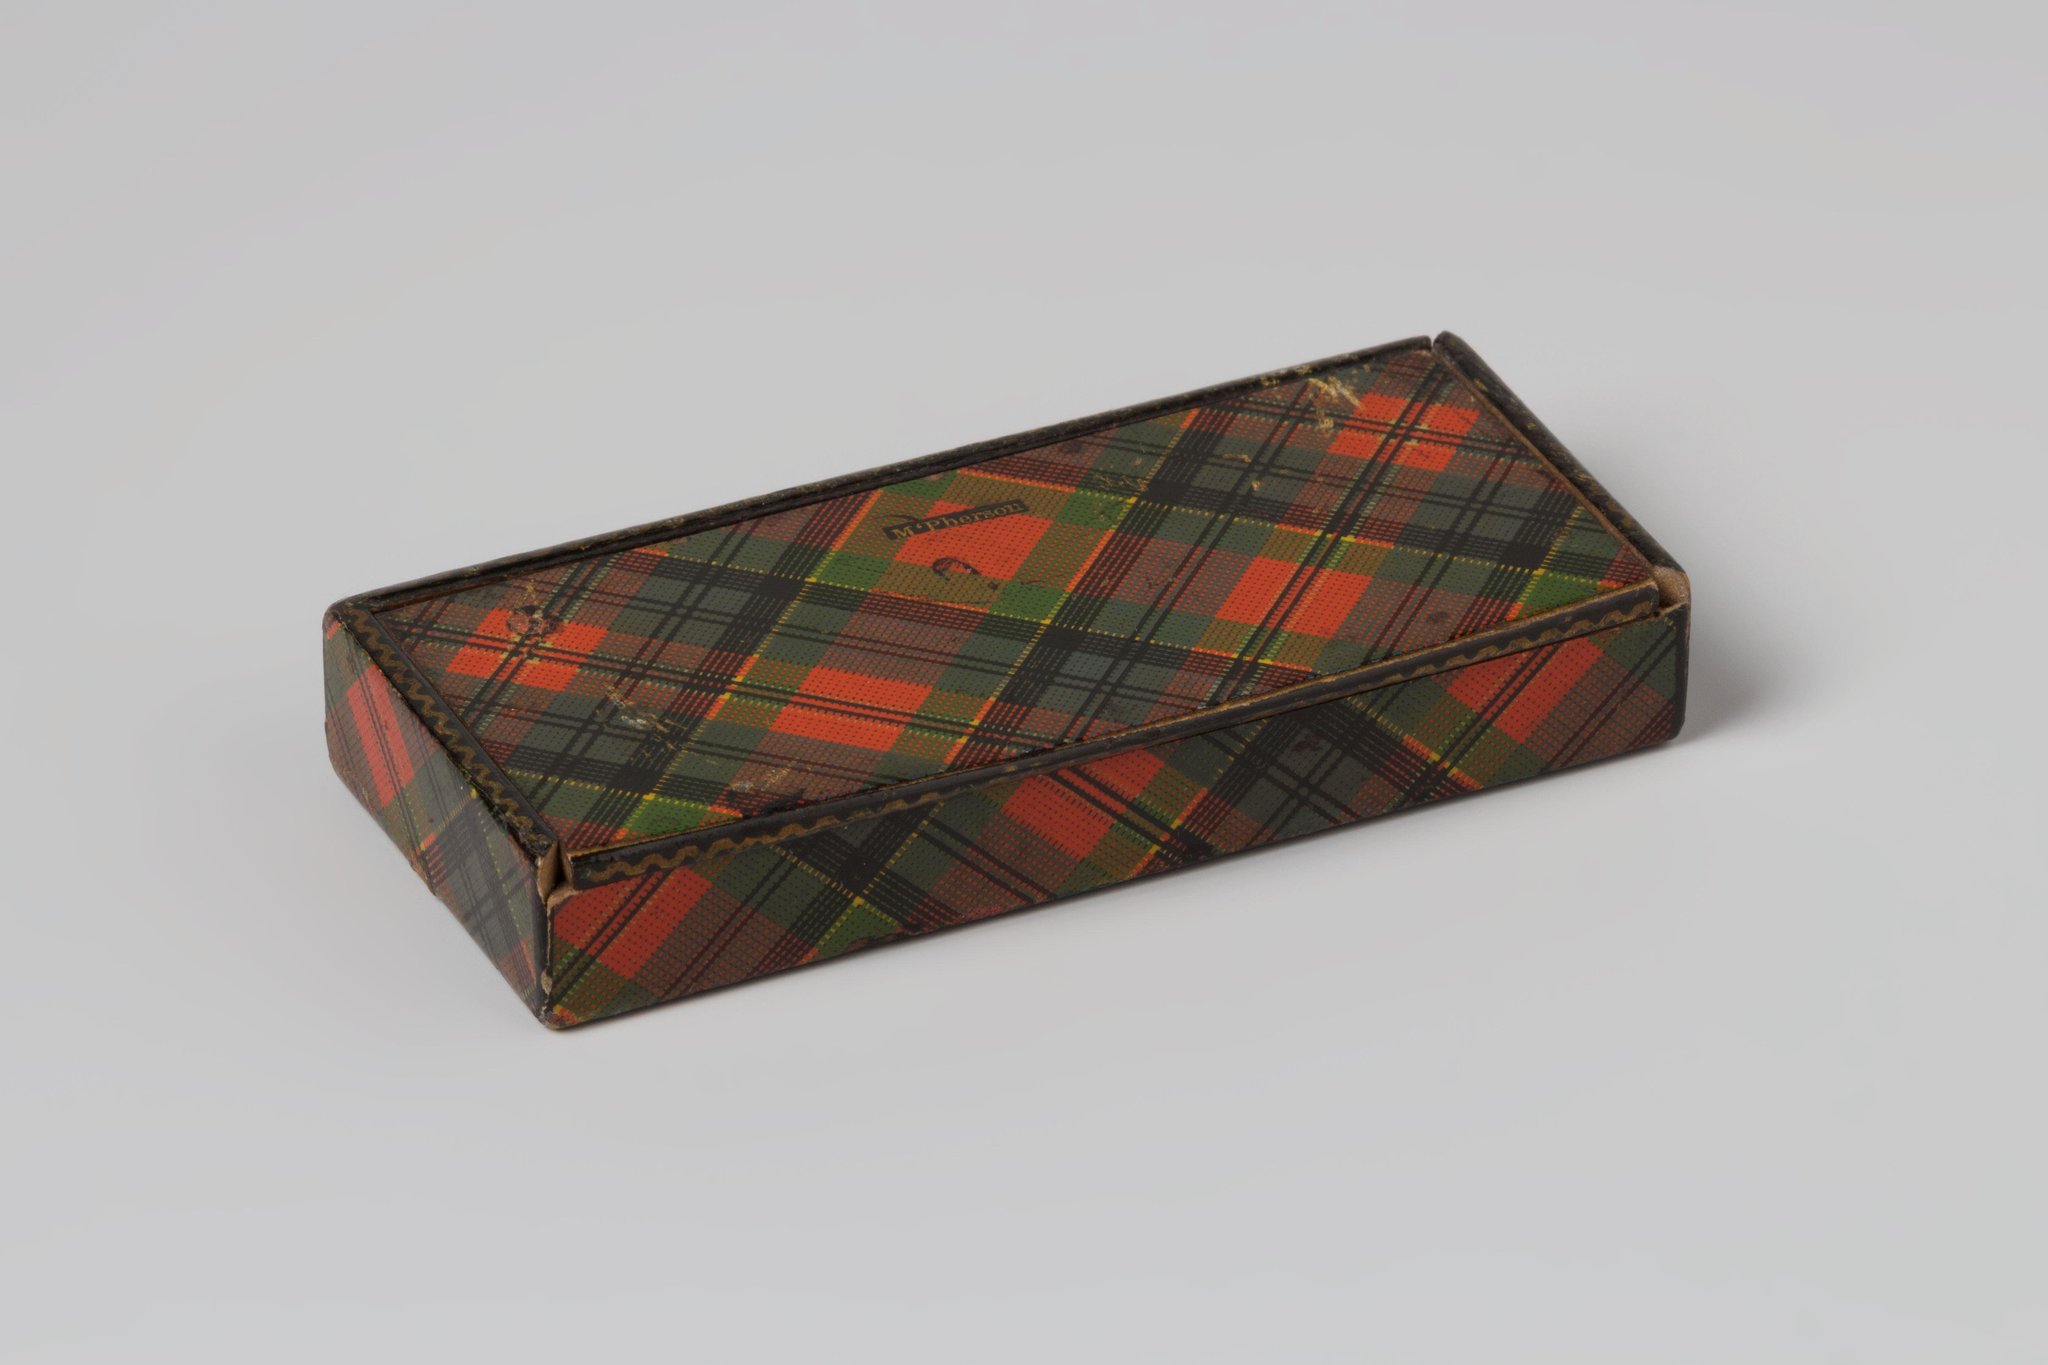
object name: stamp box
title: Postzegeldoos in tartanware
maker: Anonymous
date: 1875-1900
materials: lacquer, paper, wood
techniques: cutting, lacquer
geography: scotland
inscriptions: name: ‘'M'Pherson'’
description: Postzegeldoos in tartanware; McPherson. Plat rechthoekig met als afgerond, vooruitstekend klepdeksel. Clan: In gouden lettertjes McPherson.